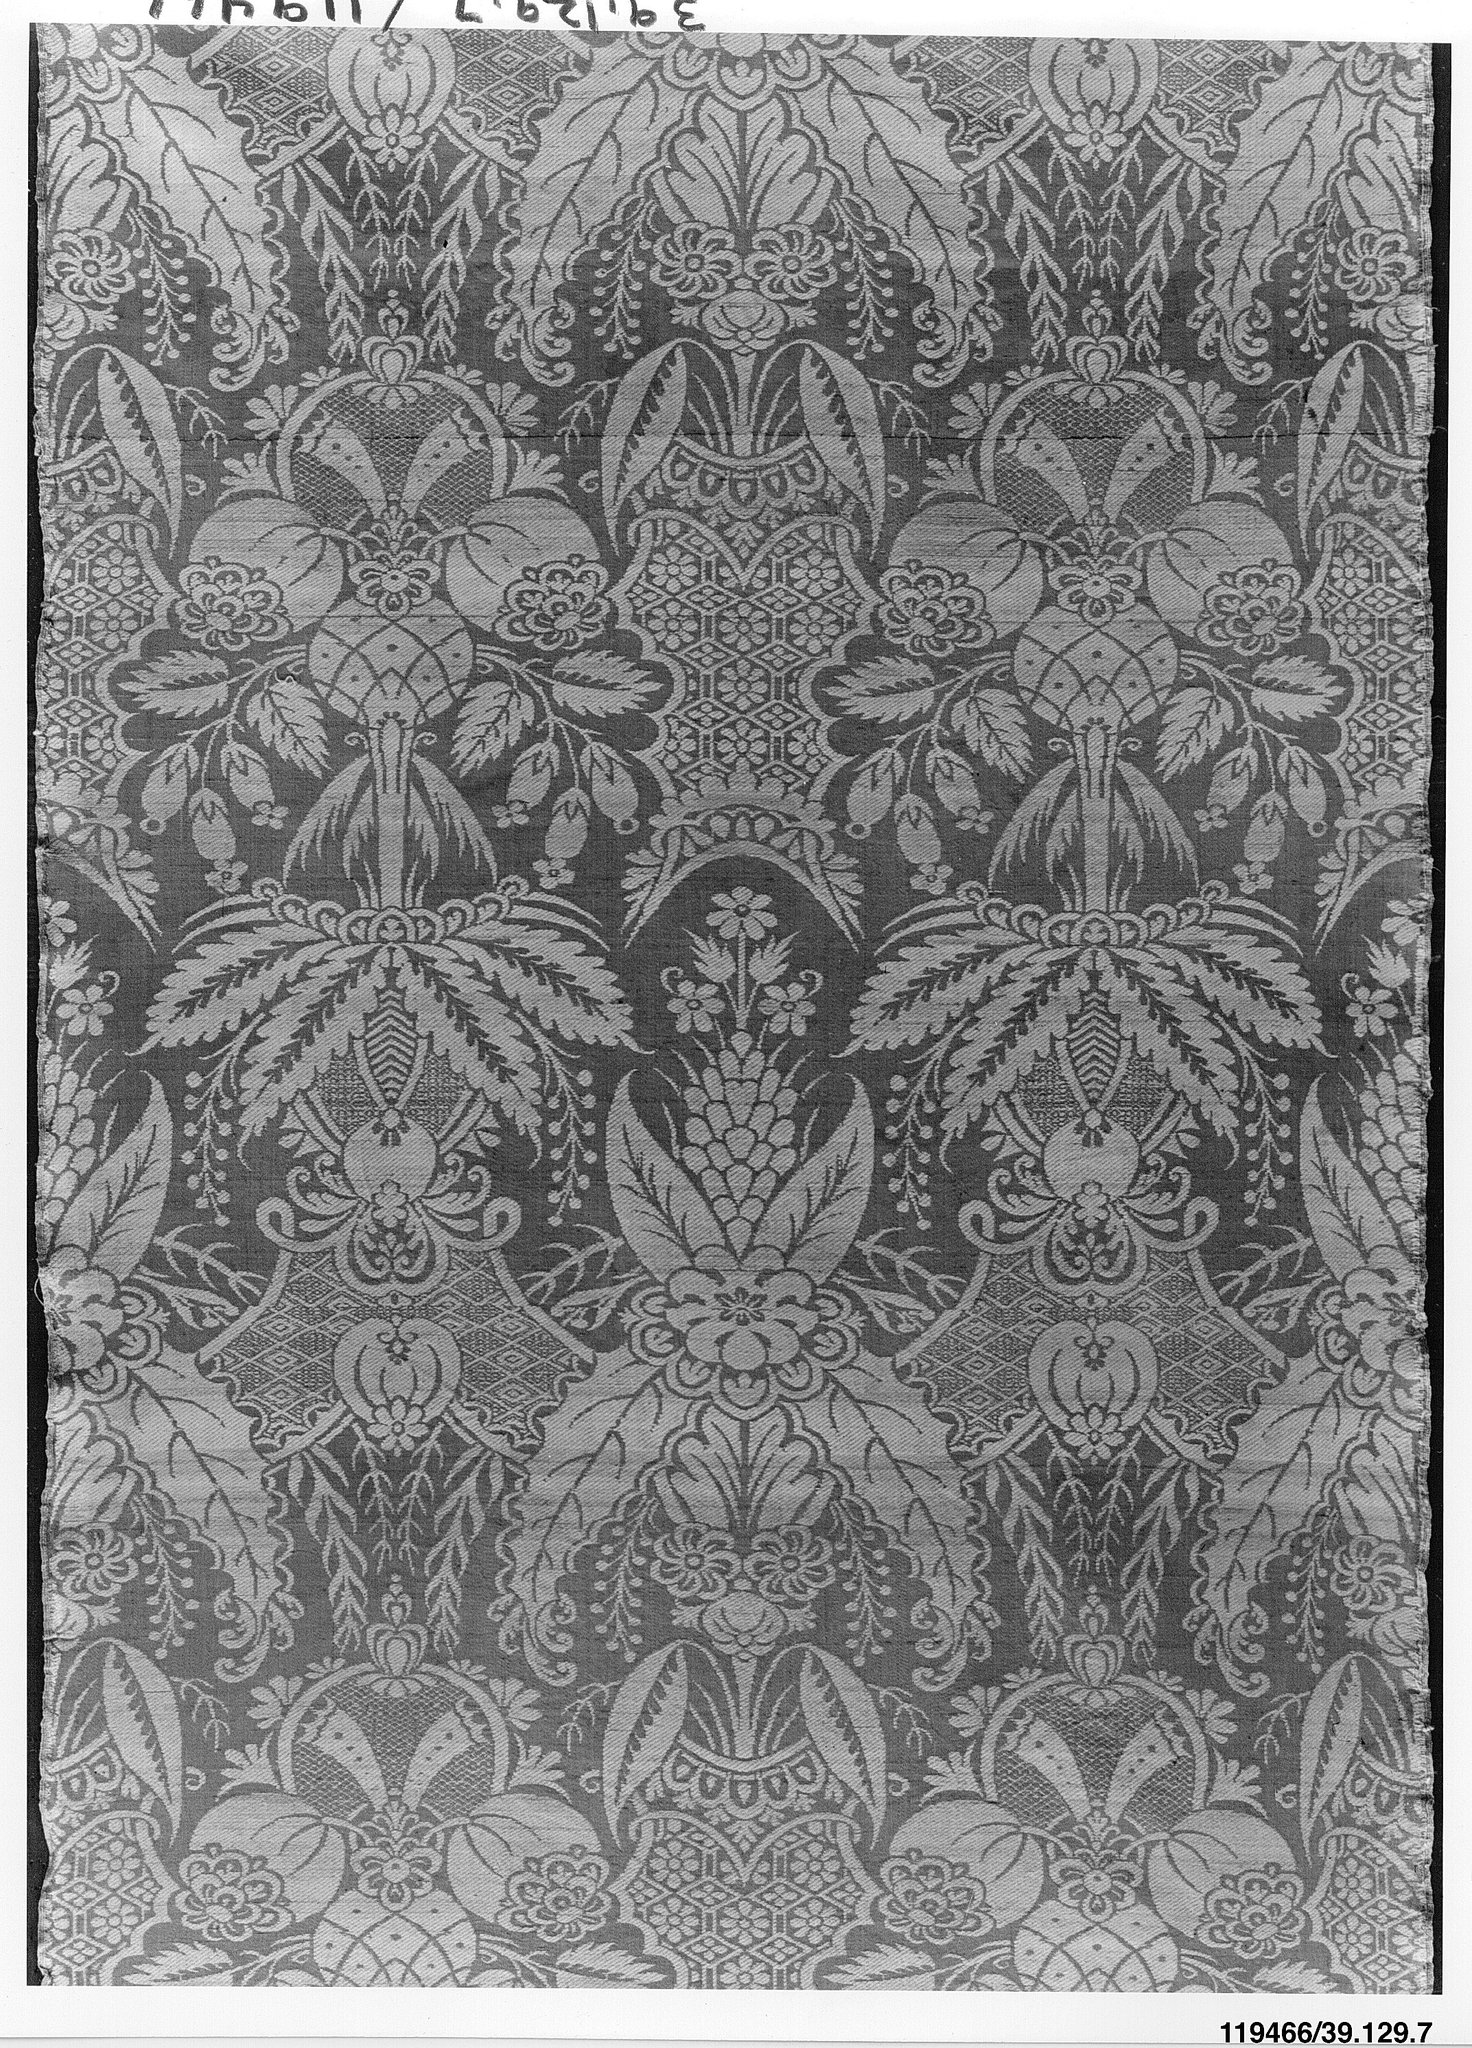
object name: piece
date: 1670-1690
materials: silk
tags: flowers,leaves